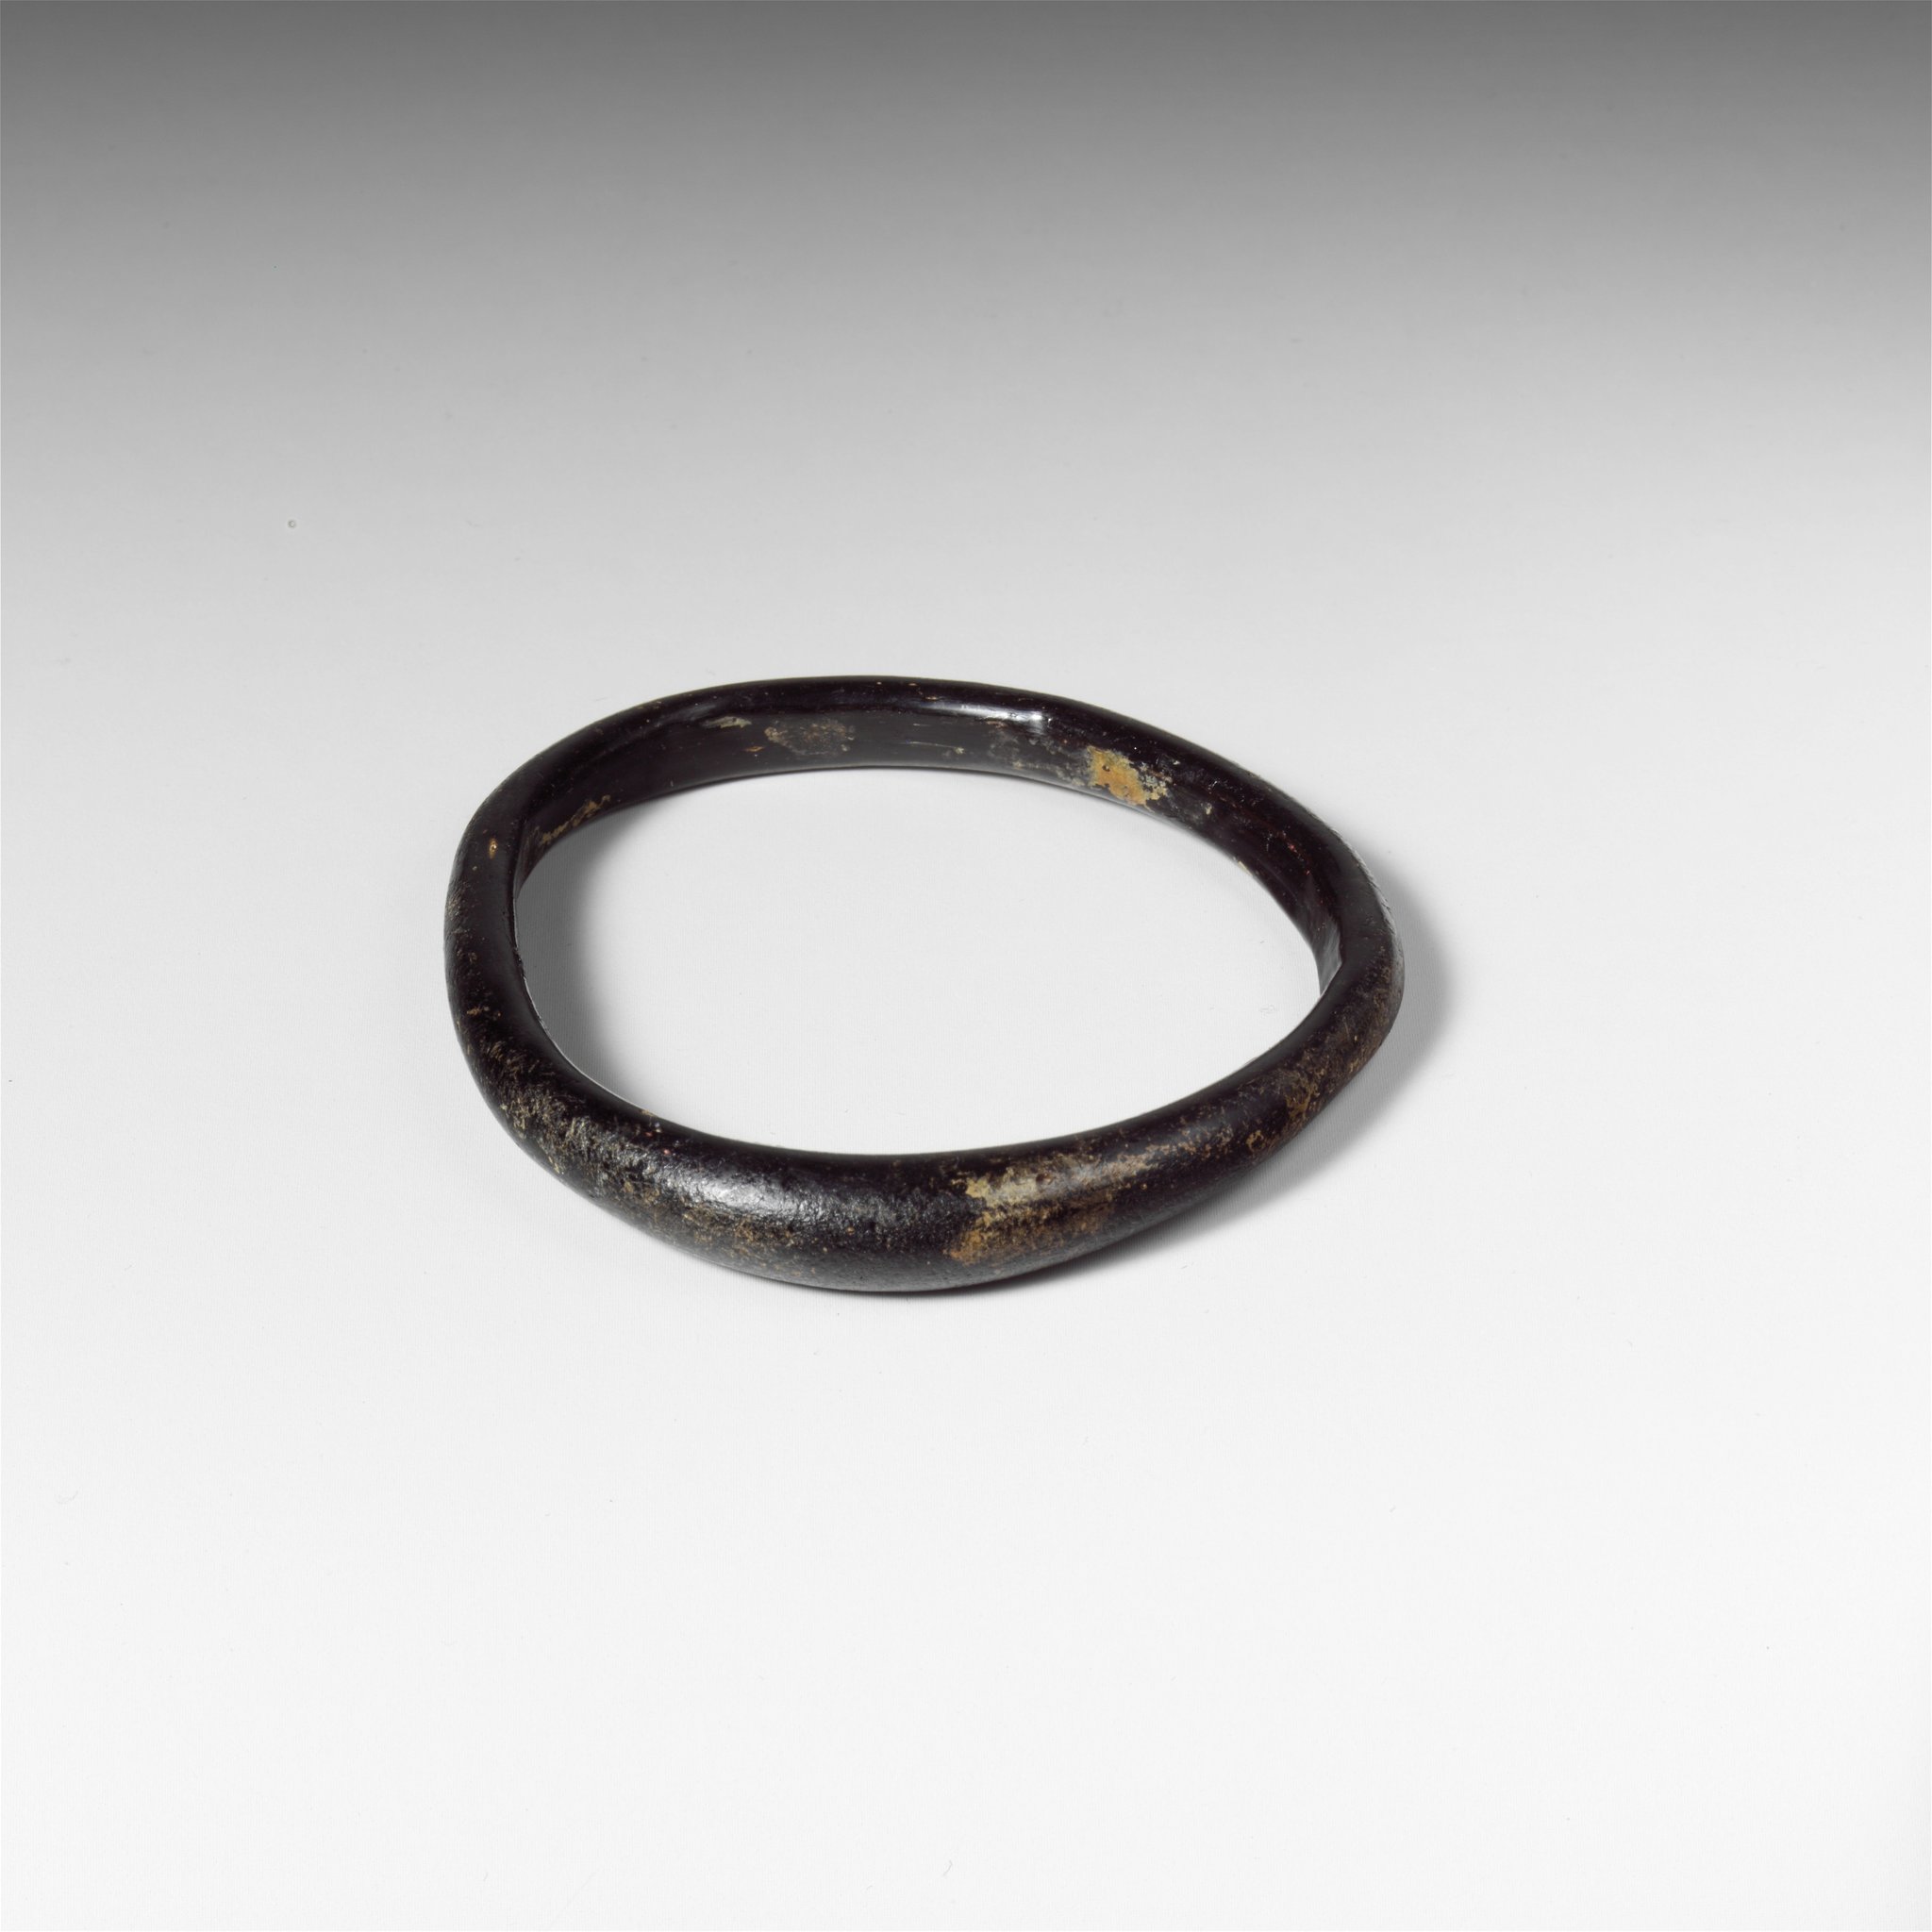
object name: bracelet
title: Glass bracelet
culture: roman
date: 101-400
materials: glass